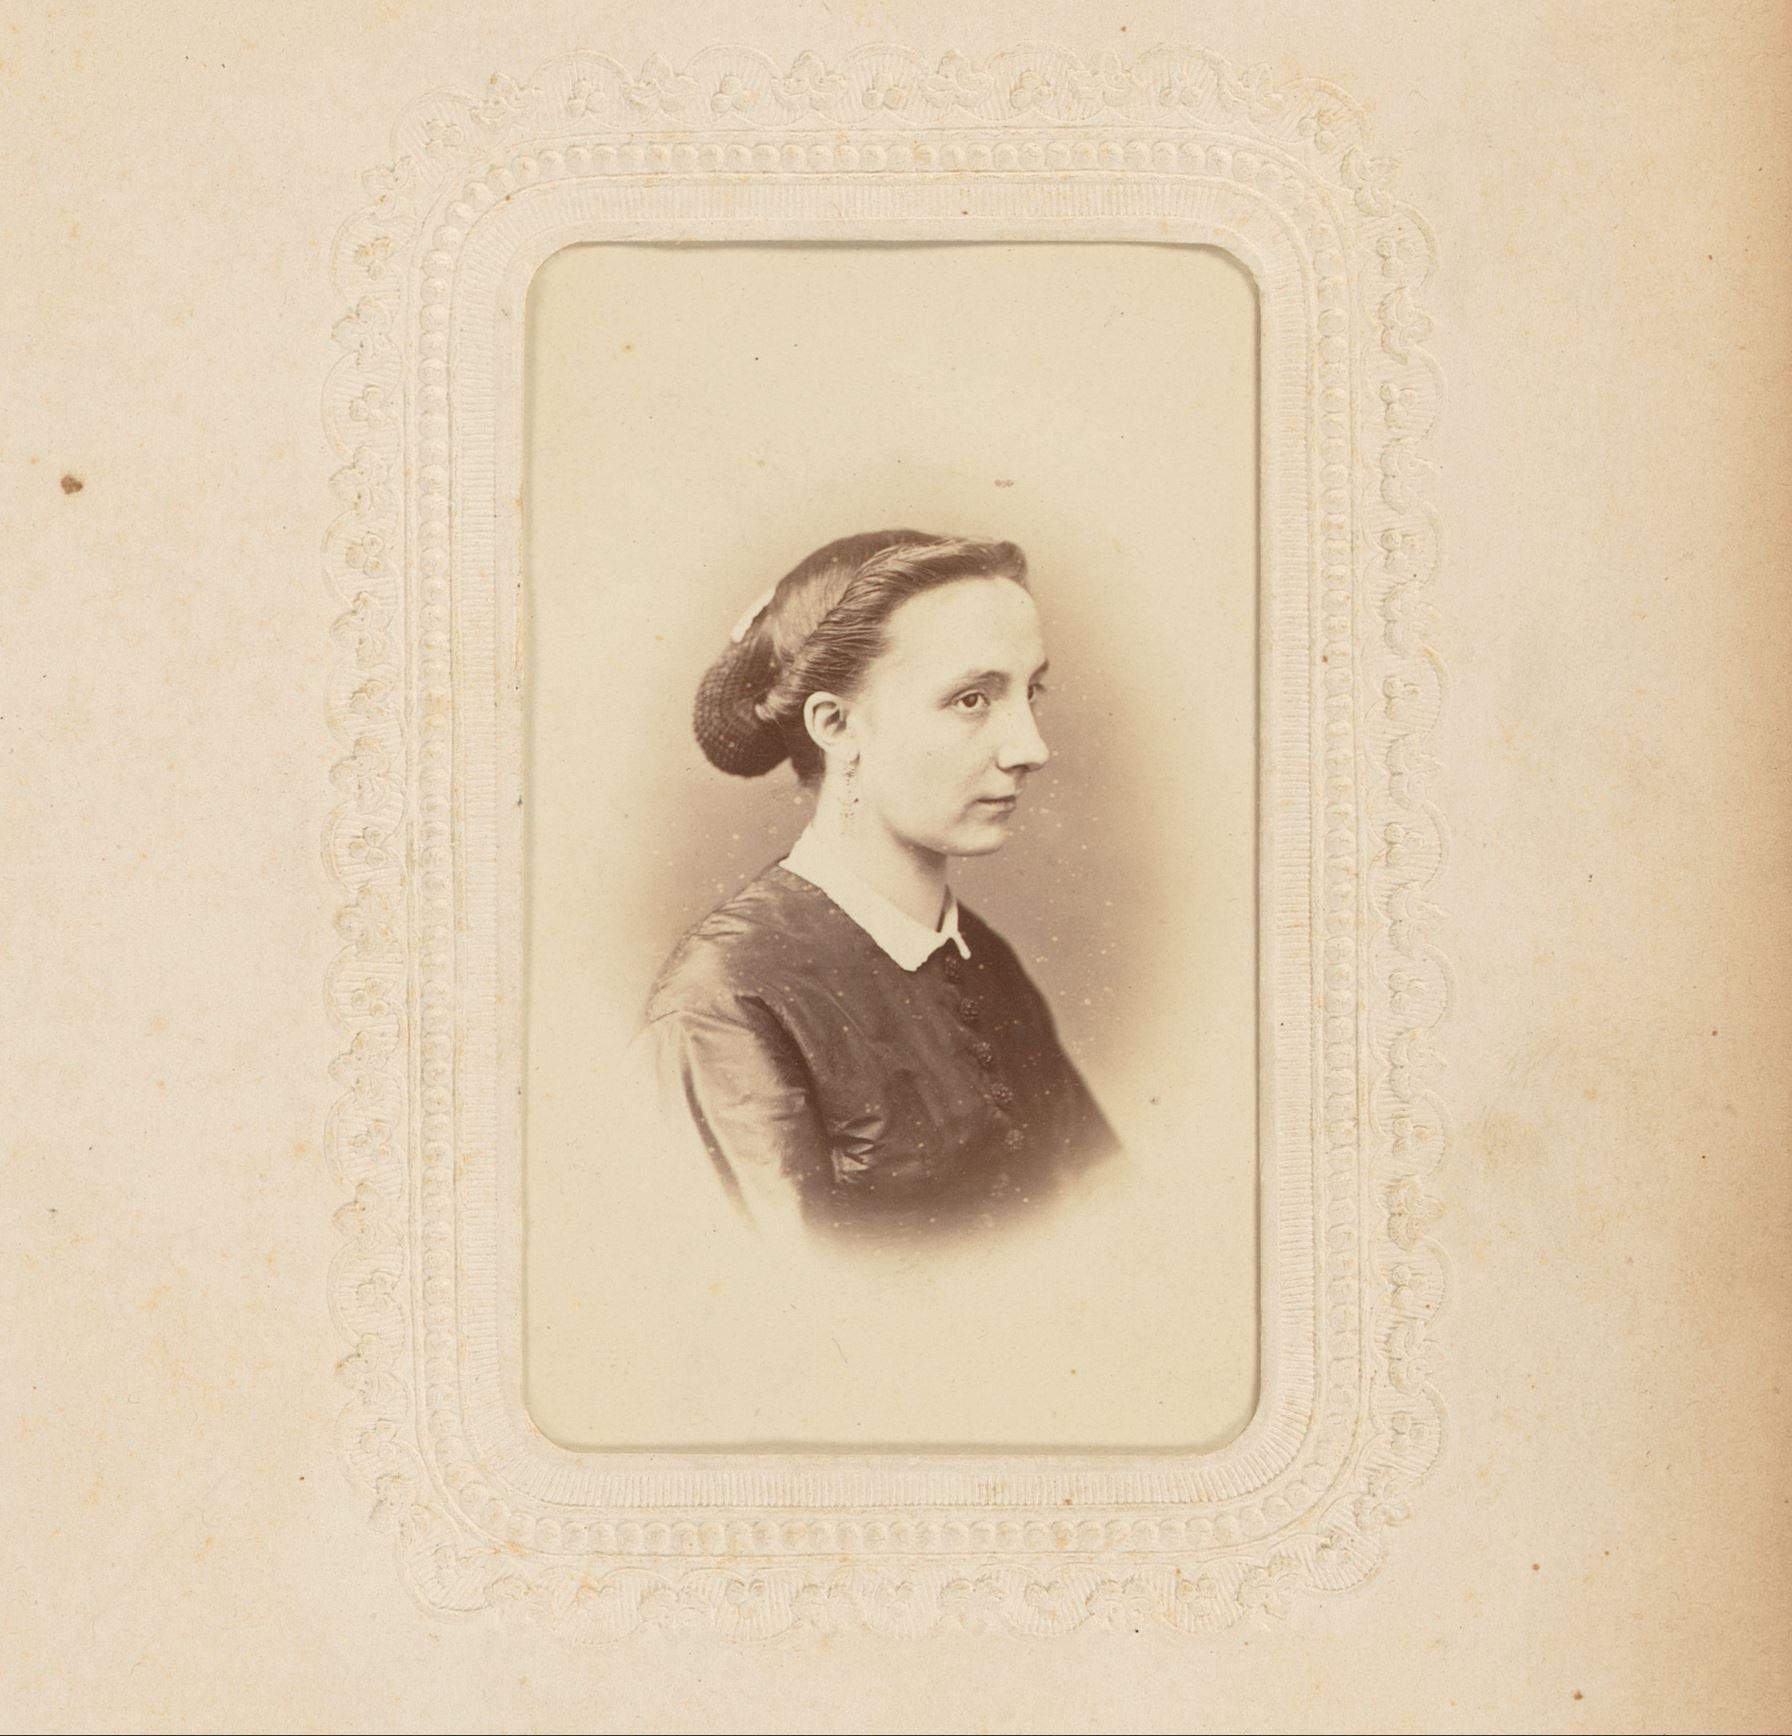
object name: photograph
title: Portret van een vrouw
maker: pierre-jean cornelisse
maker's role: fotograaf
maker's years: 1827-1901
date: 1860-1890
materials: cardboard, photographic support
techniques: albumen print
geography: brussels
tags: historical persons - bb - woman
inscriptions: inscription: ‘Cornelisse/ 38 Rue de l'Écuyer/ à/ Bruxelles/ Rotterdam/ Tilburg/ English spoken (...)’